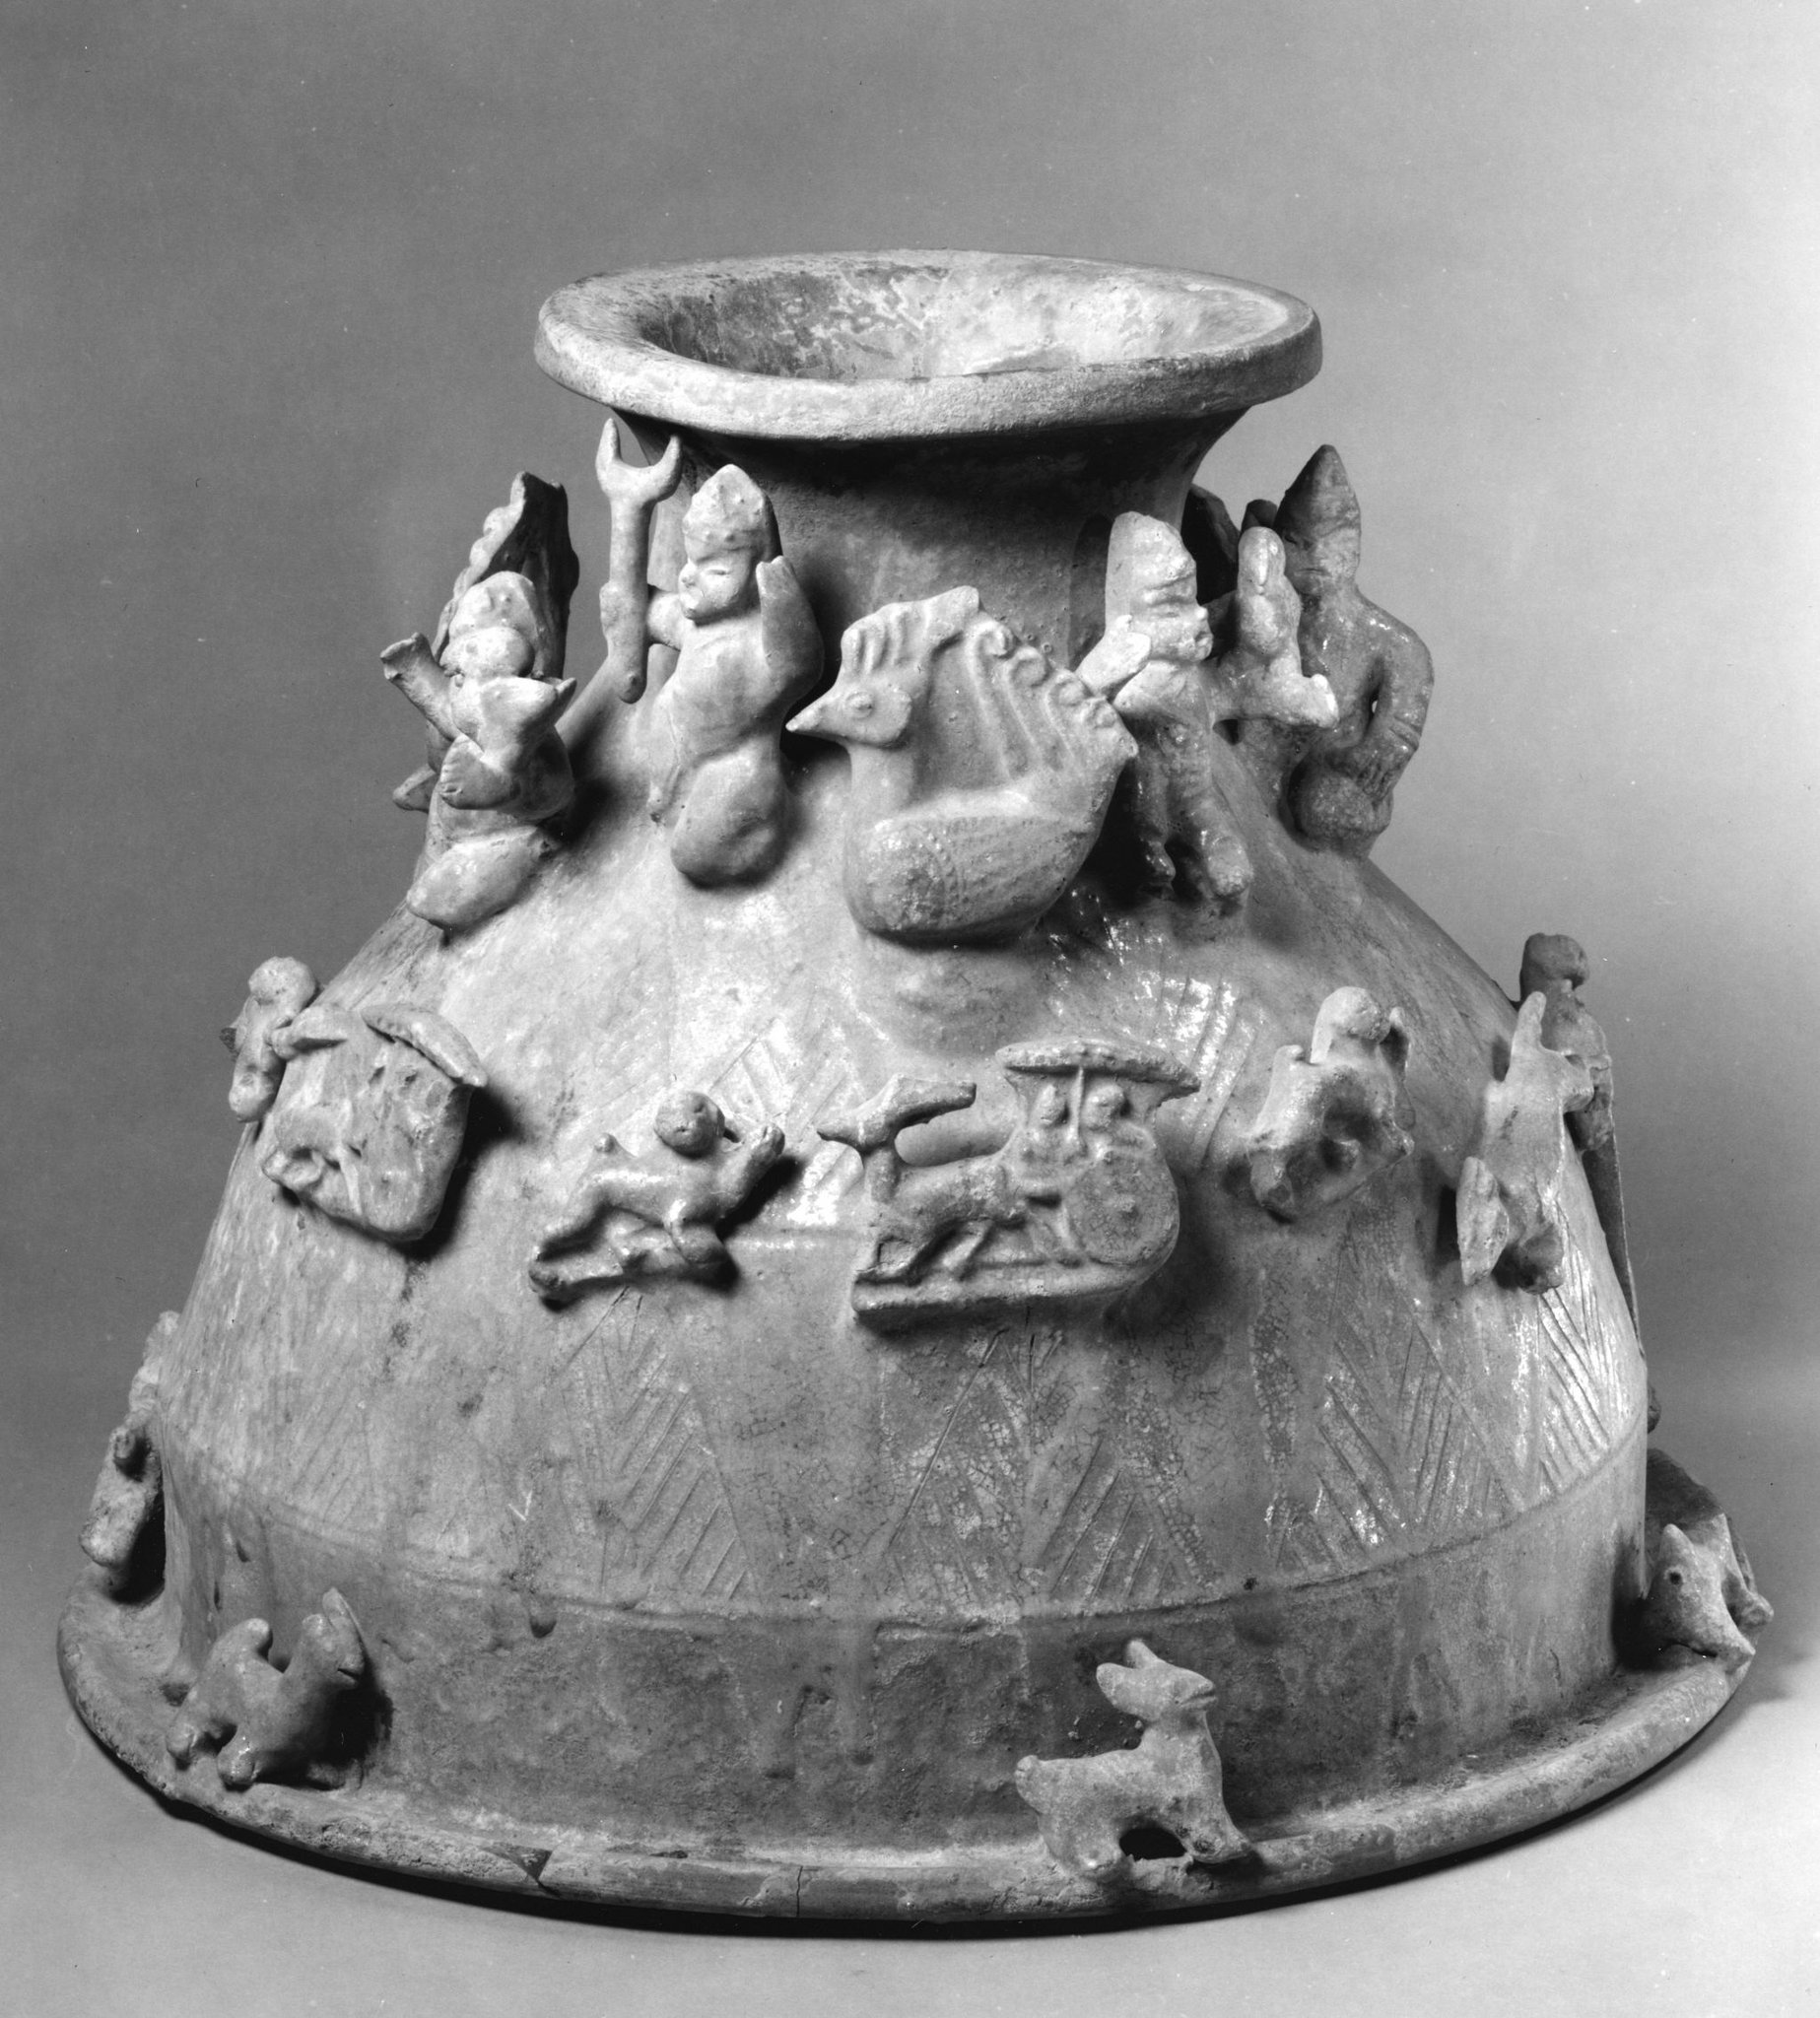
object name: lamp stand model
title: Model of a Bell-Shaped Lamp Stand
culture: chinese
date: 1-200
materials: earthenware, glaze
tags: human figures,birds,carriages